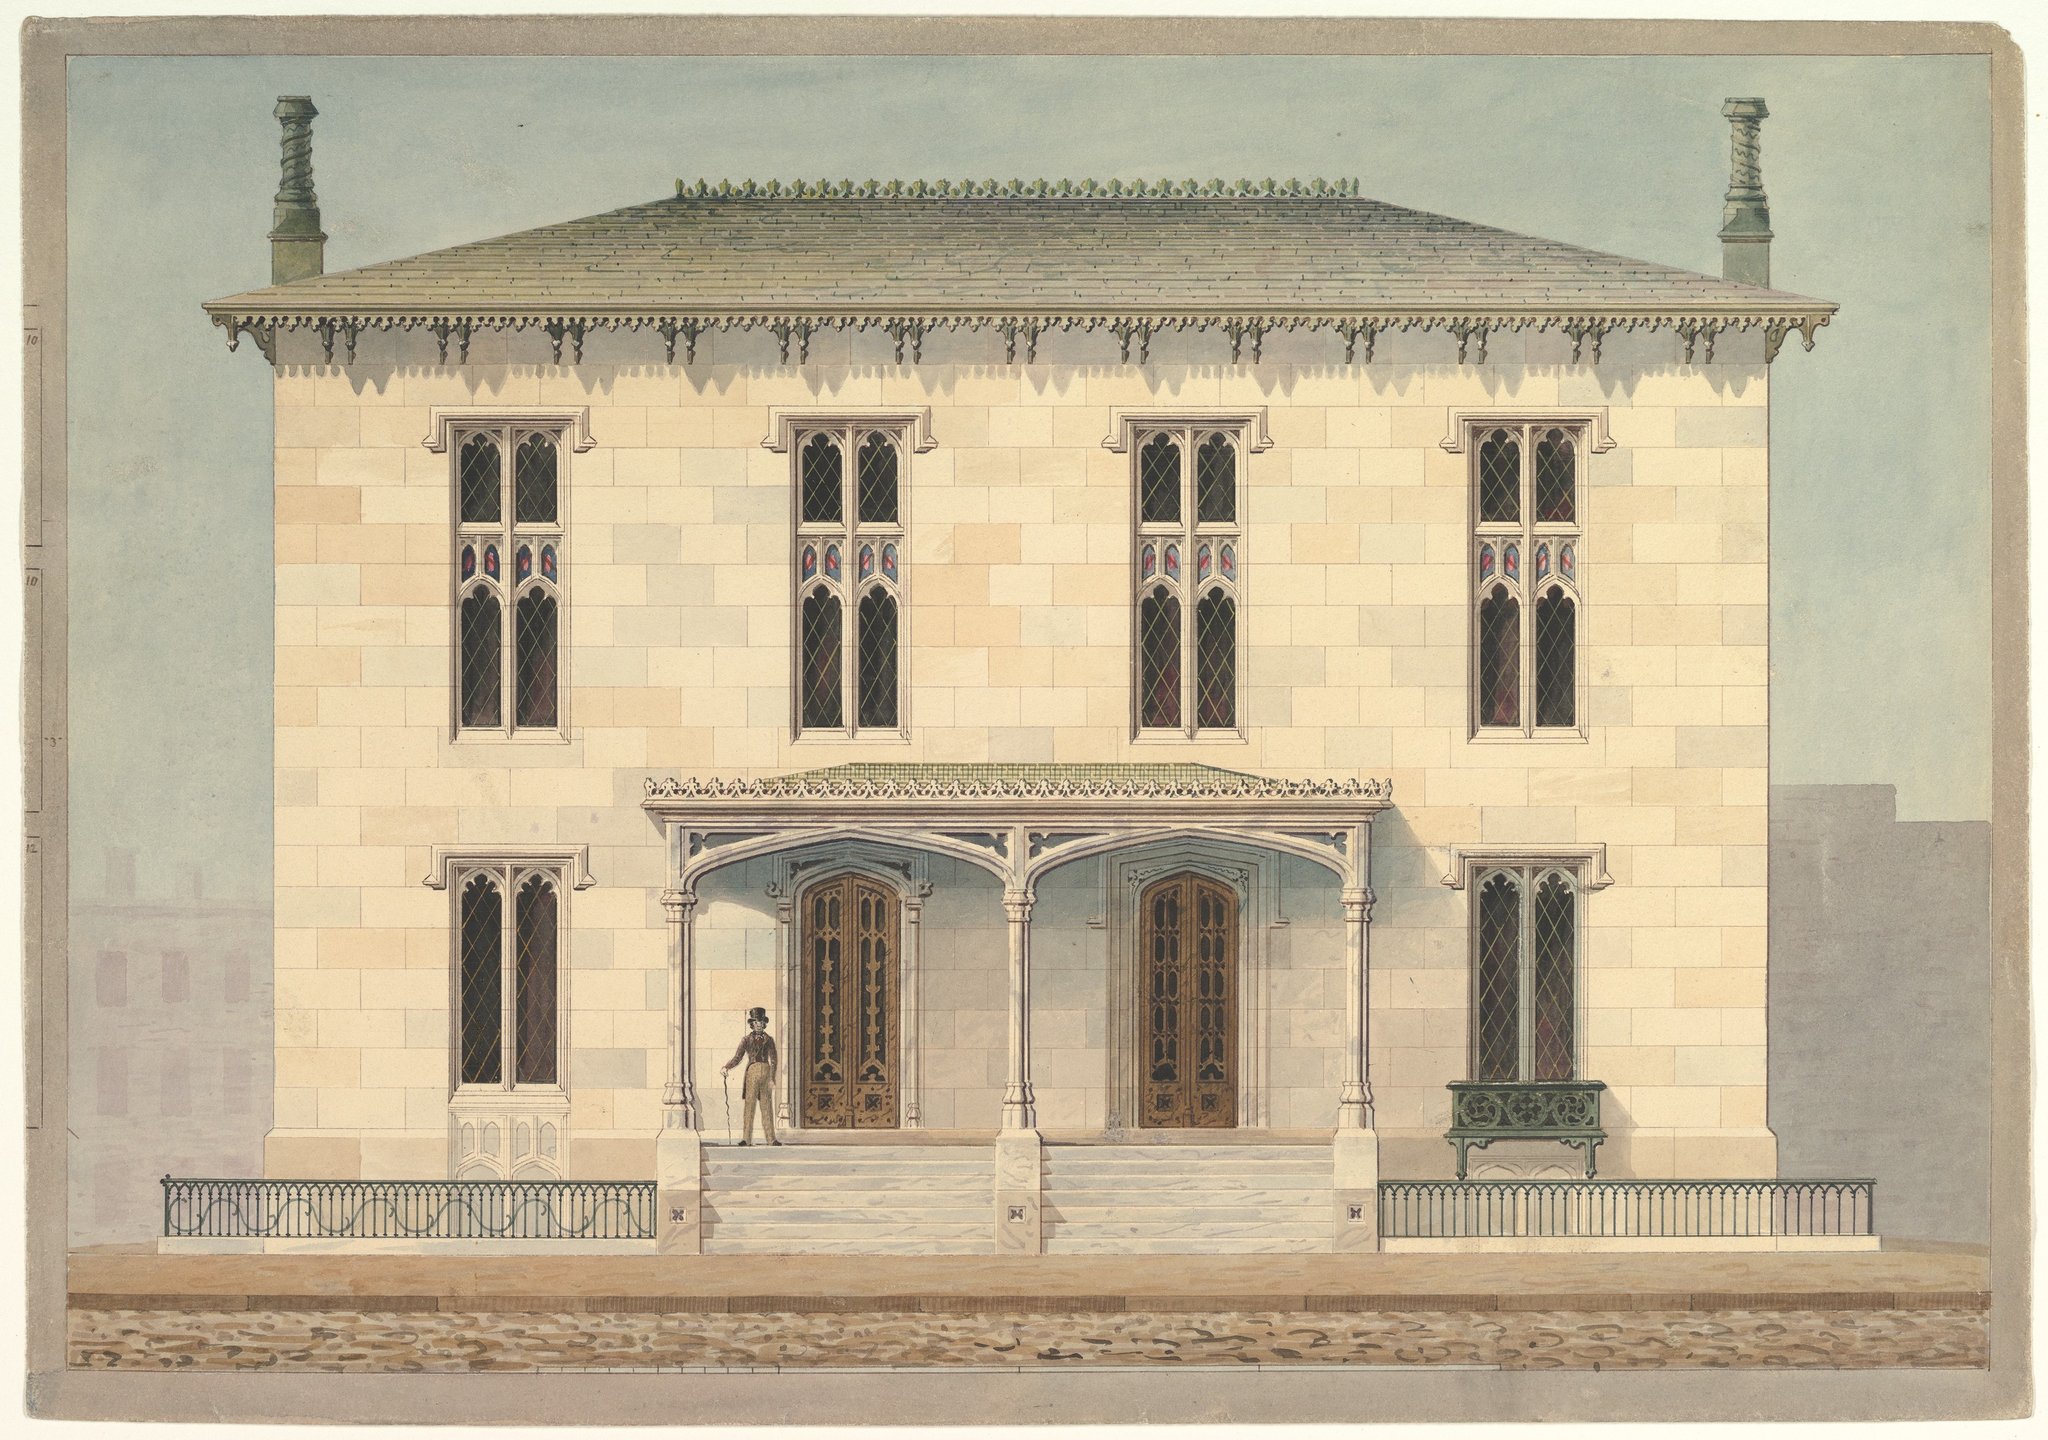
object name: drawing ornament architecture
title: Design for a Double Townhouse (front elevation)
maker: alexander jackson davis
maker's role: artist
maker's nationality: american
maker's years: 1803-1892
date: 1843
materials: ink, paper, watercolor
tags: architecture,houses